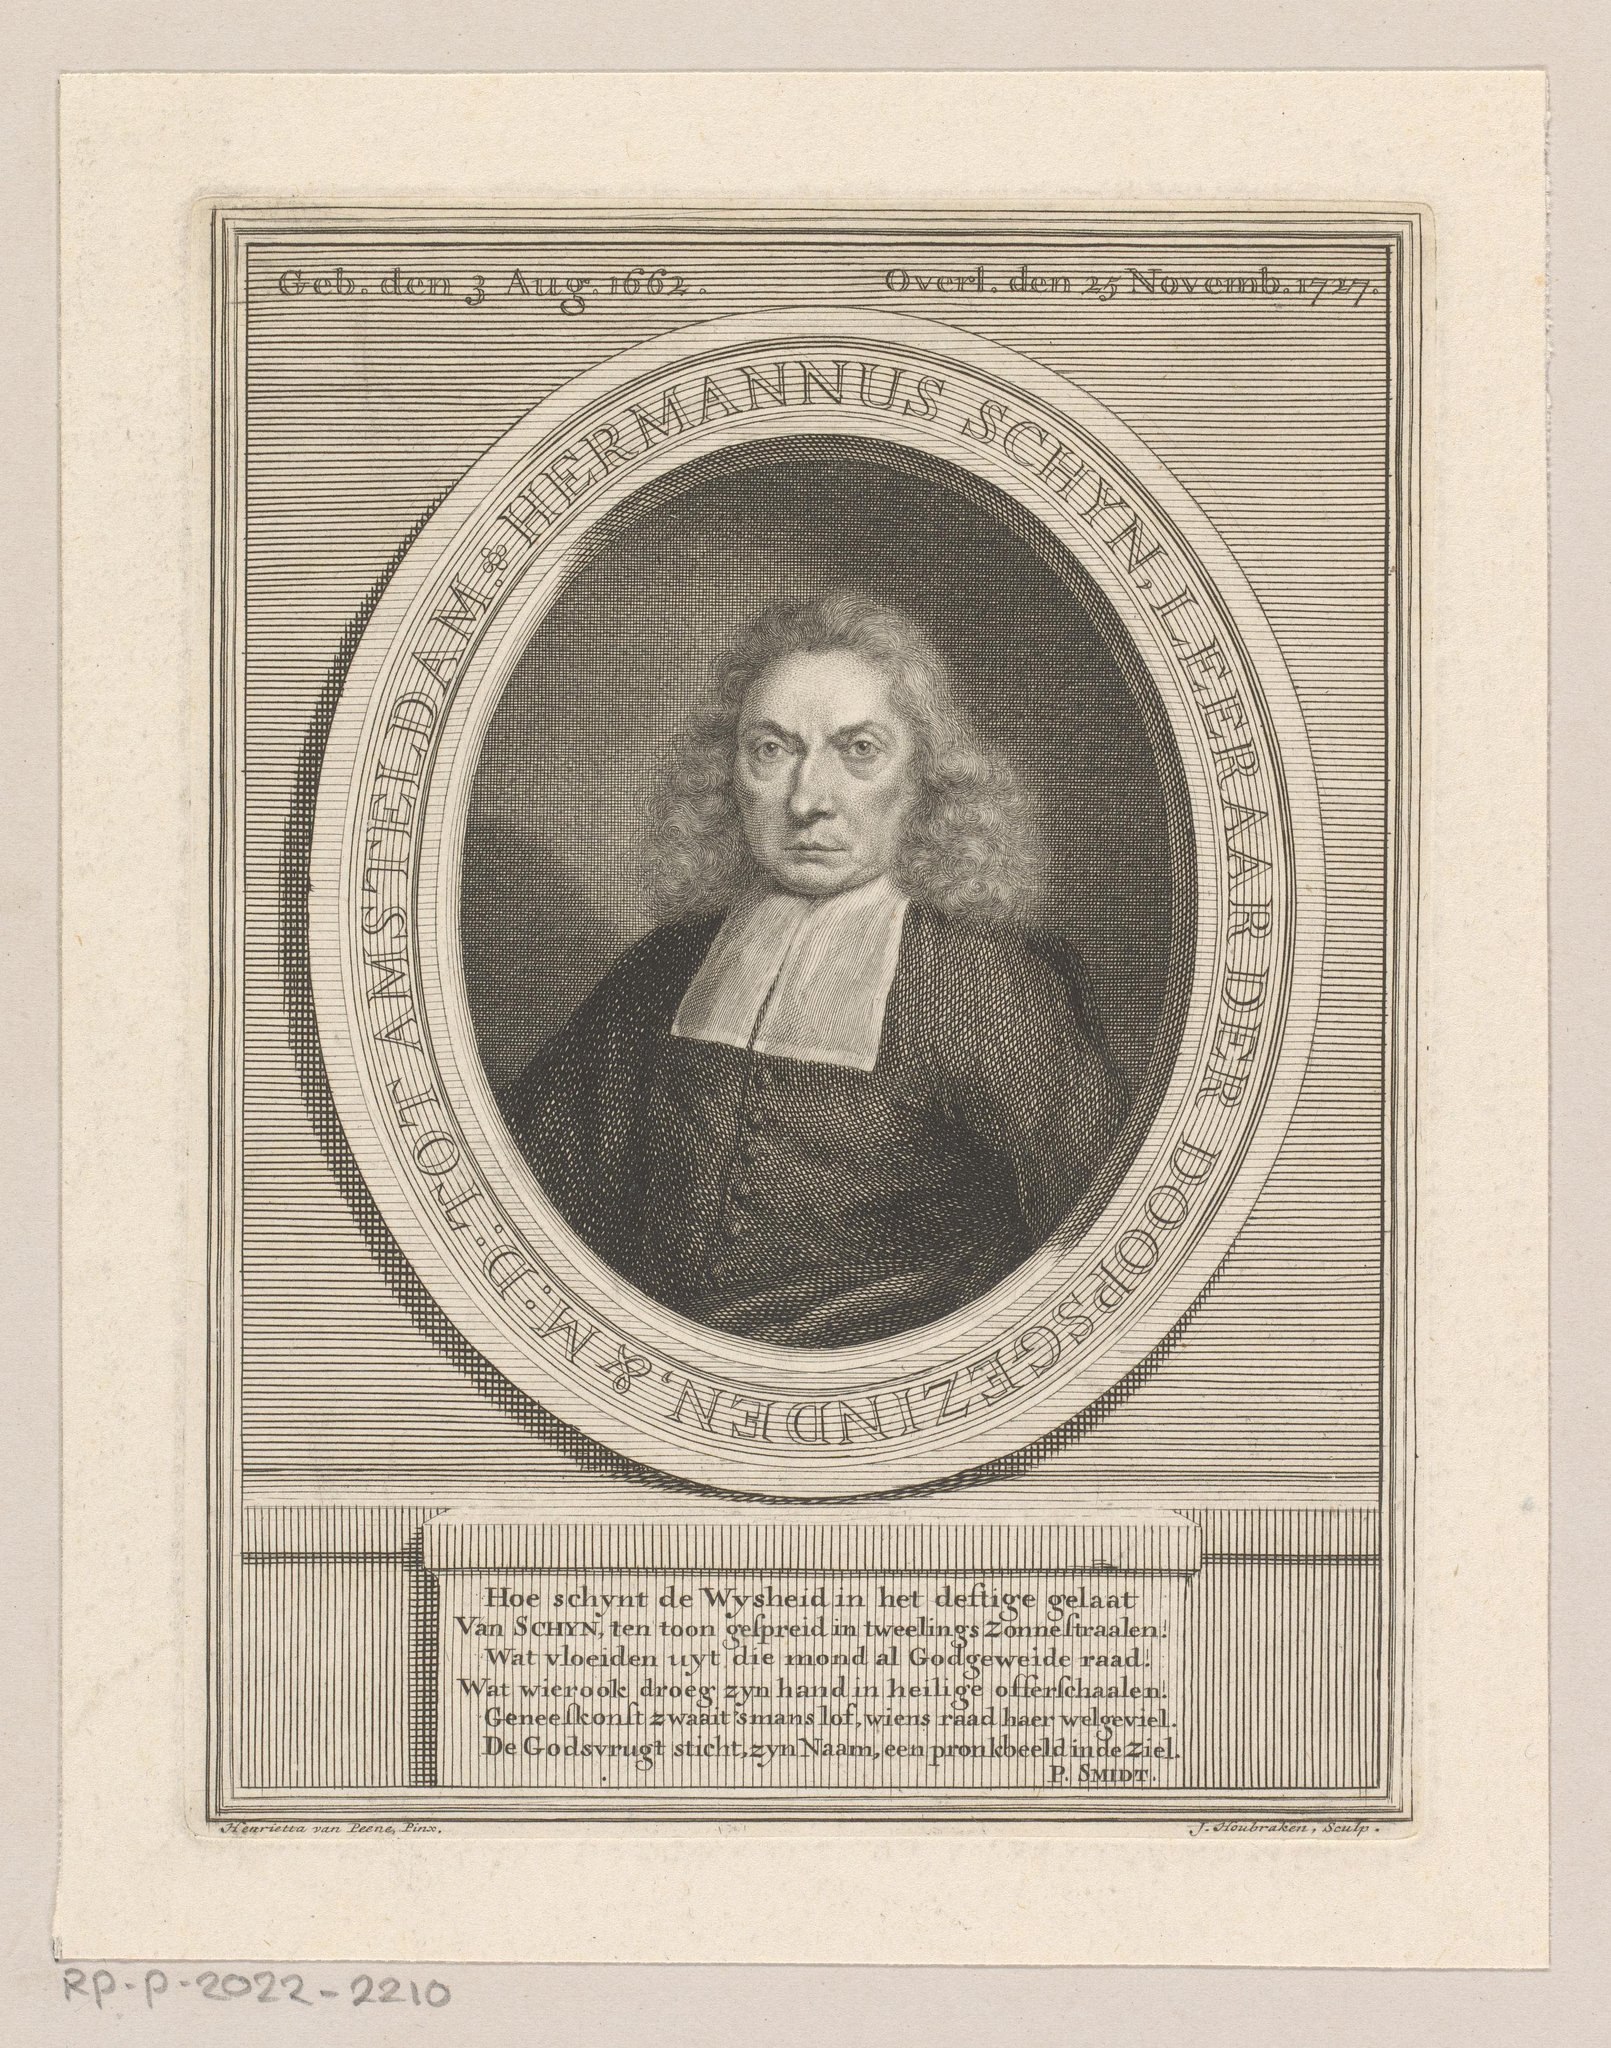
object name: print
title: Portret van Herman Schijn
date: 1733-1780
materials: paper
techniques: engraving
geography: amsterdam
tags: amsterdam, historical persons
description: Latere staat van deze prent gebruikt in: Schijn, Herman. Heilige keurstoffen over uitgeleezene texten des Ouden en Nieuwen Testaments (...). Amsterdam: Jacobus en Gerardus Borstius, 1733.